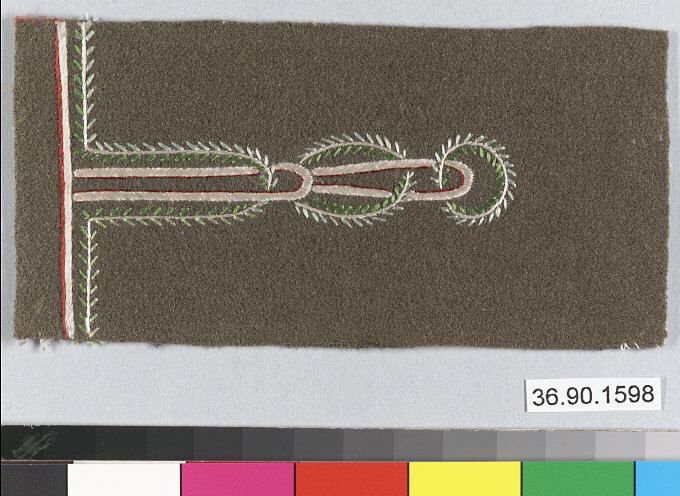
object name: sample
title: Embroidery sample for a man’s suit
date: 1785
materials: silk, wool